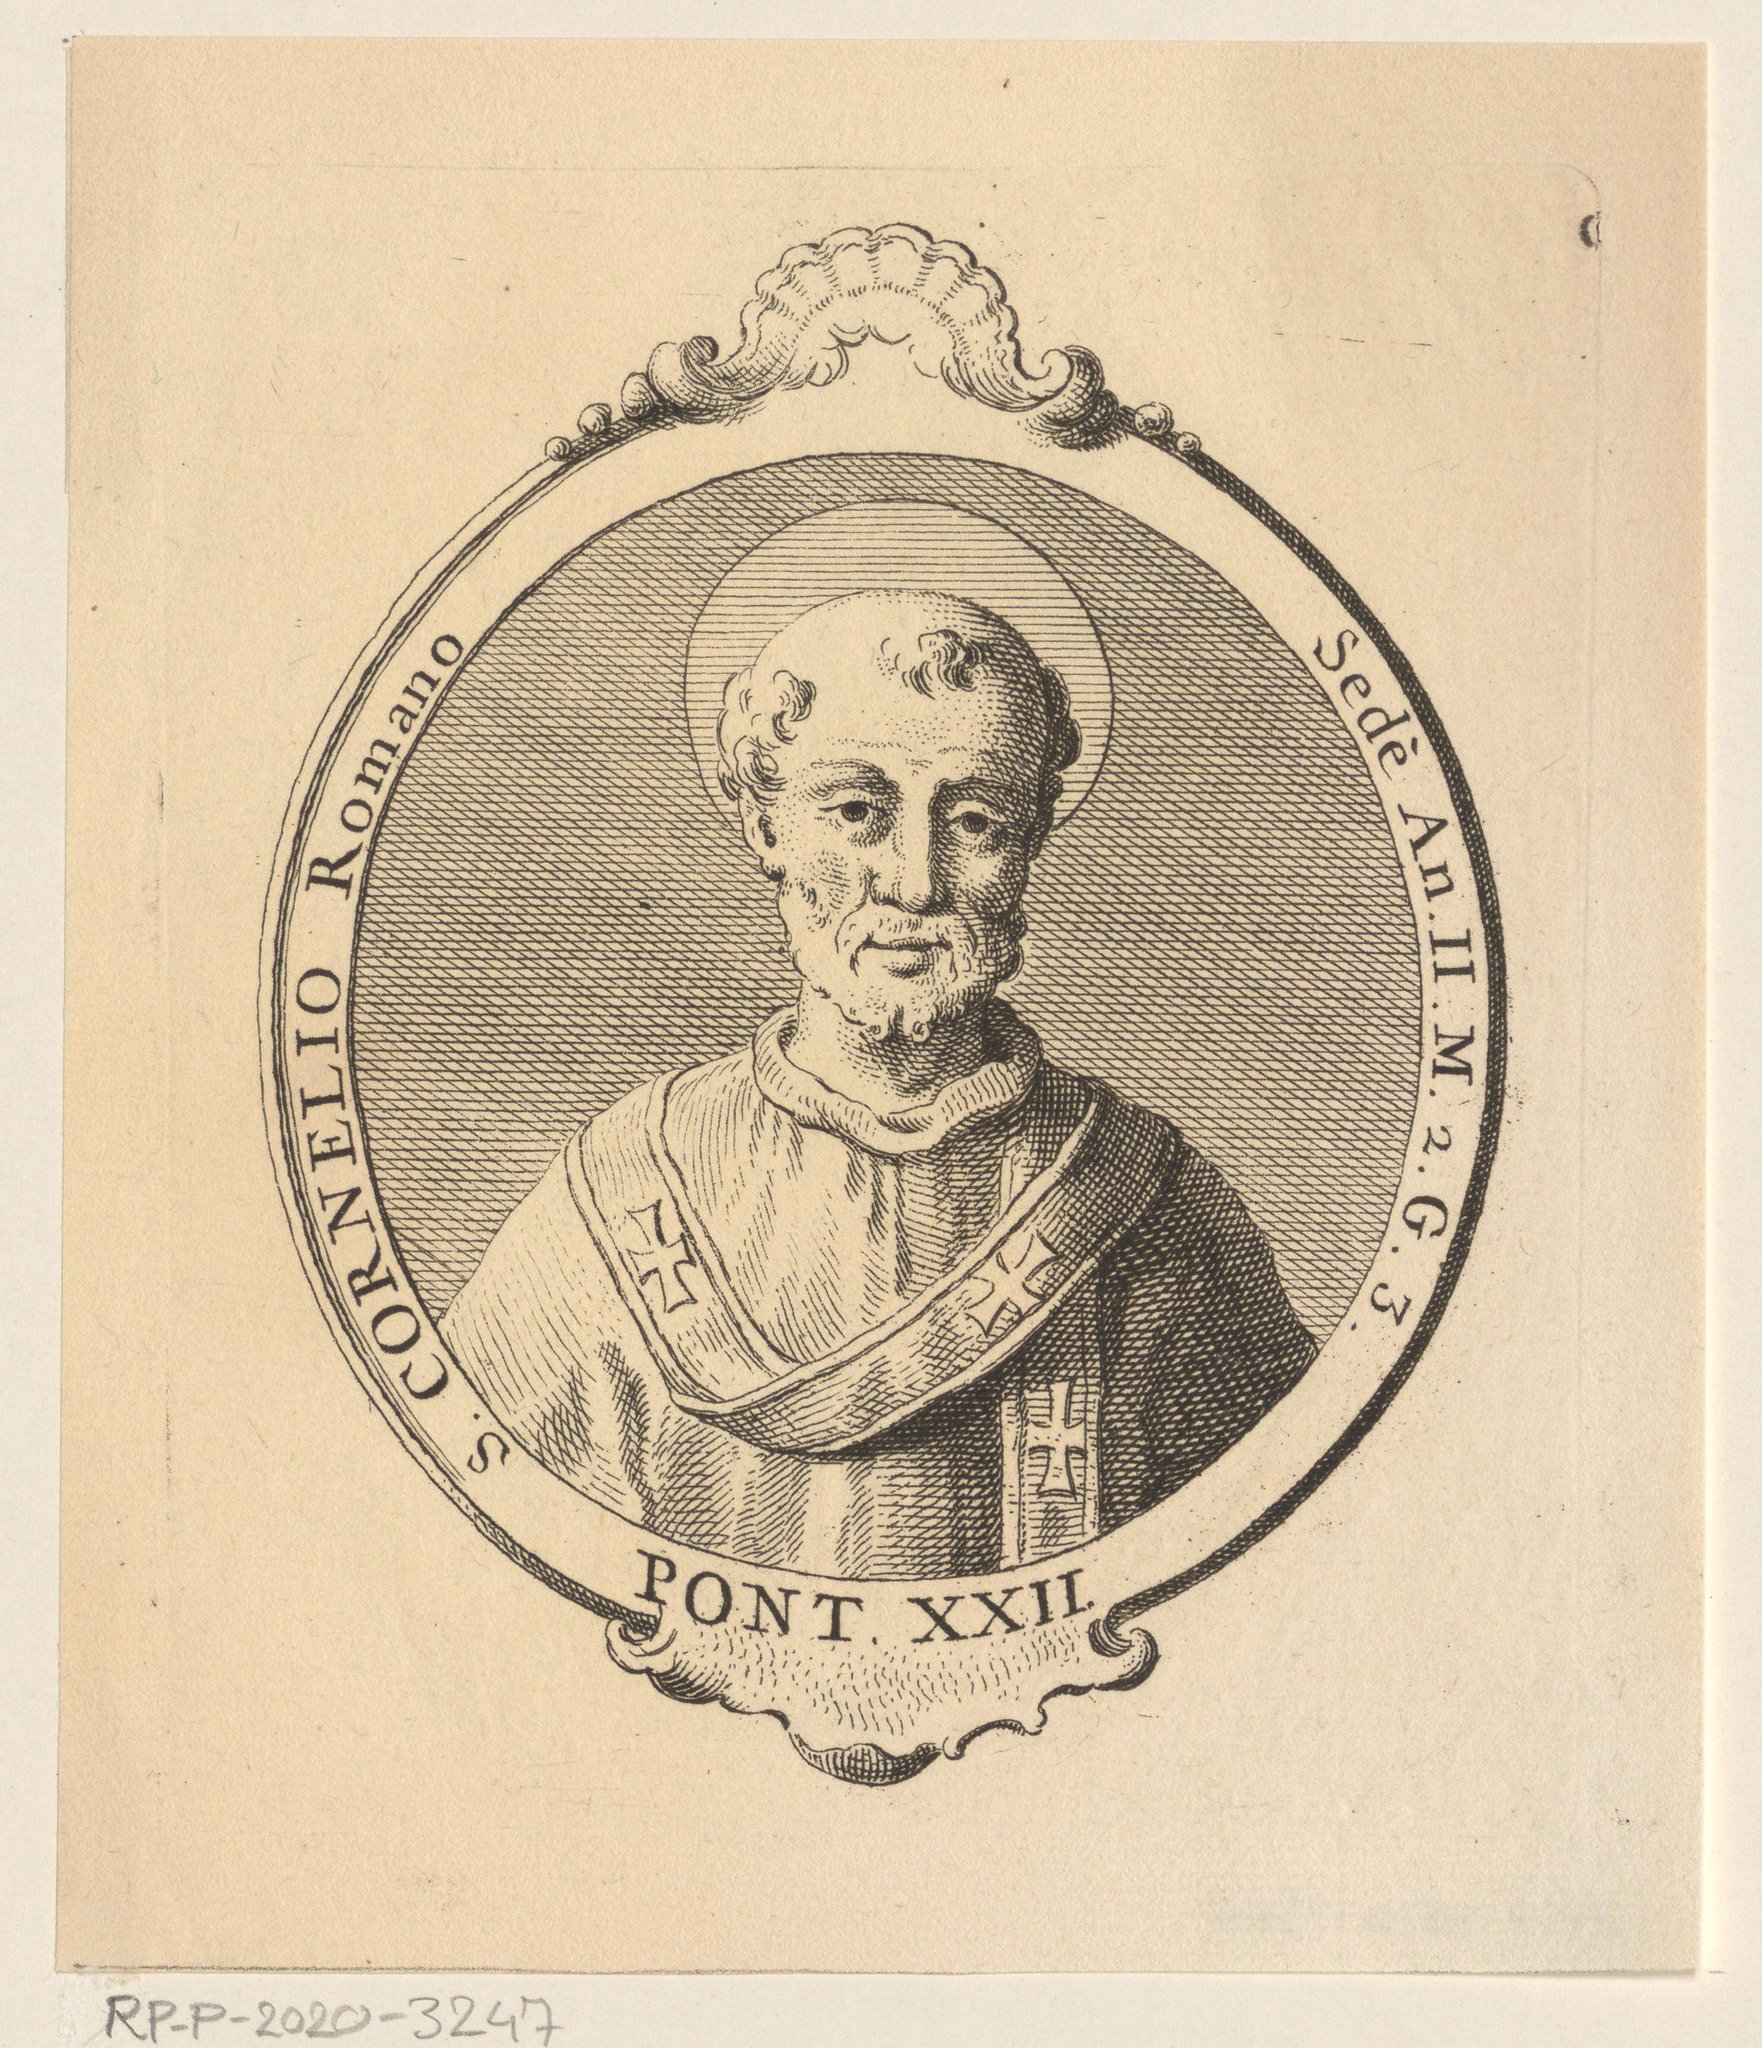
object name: print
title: Portret van paus Cornelius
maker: Anonymous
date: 1775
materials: paper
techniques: engraving, etching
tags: rome, historical persons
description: Prent waarschijnlijk uit: Effigies Romanorum pontificum a S. Petro ad Pium VI (...). 2 dln. Venetië en Bassano del Grappa: Giuseppe Remondini, 1775.